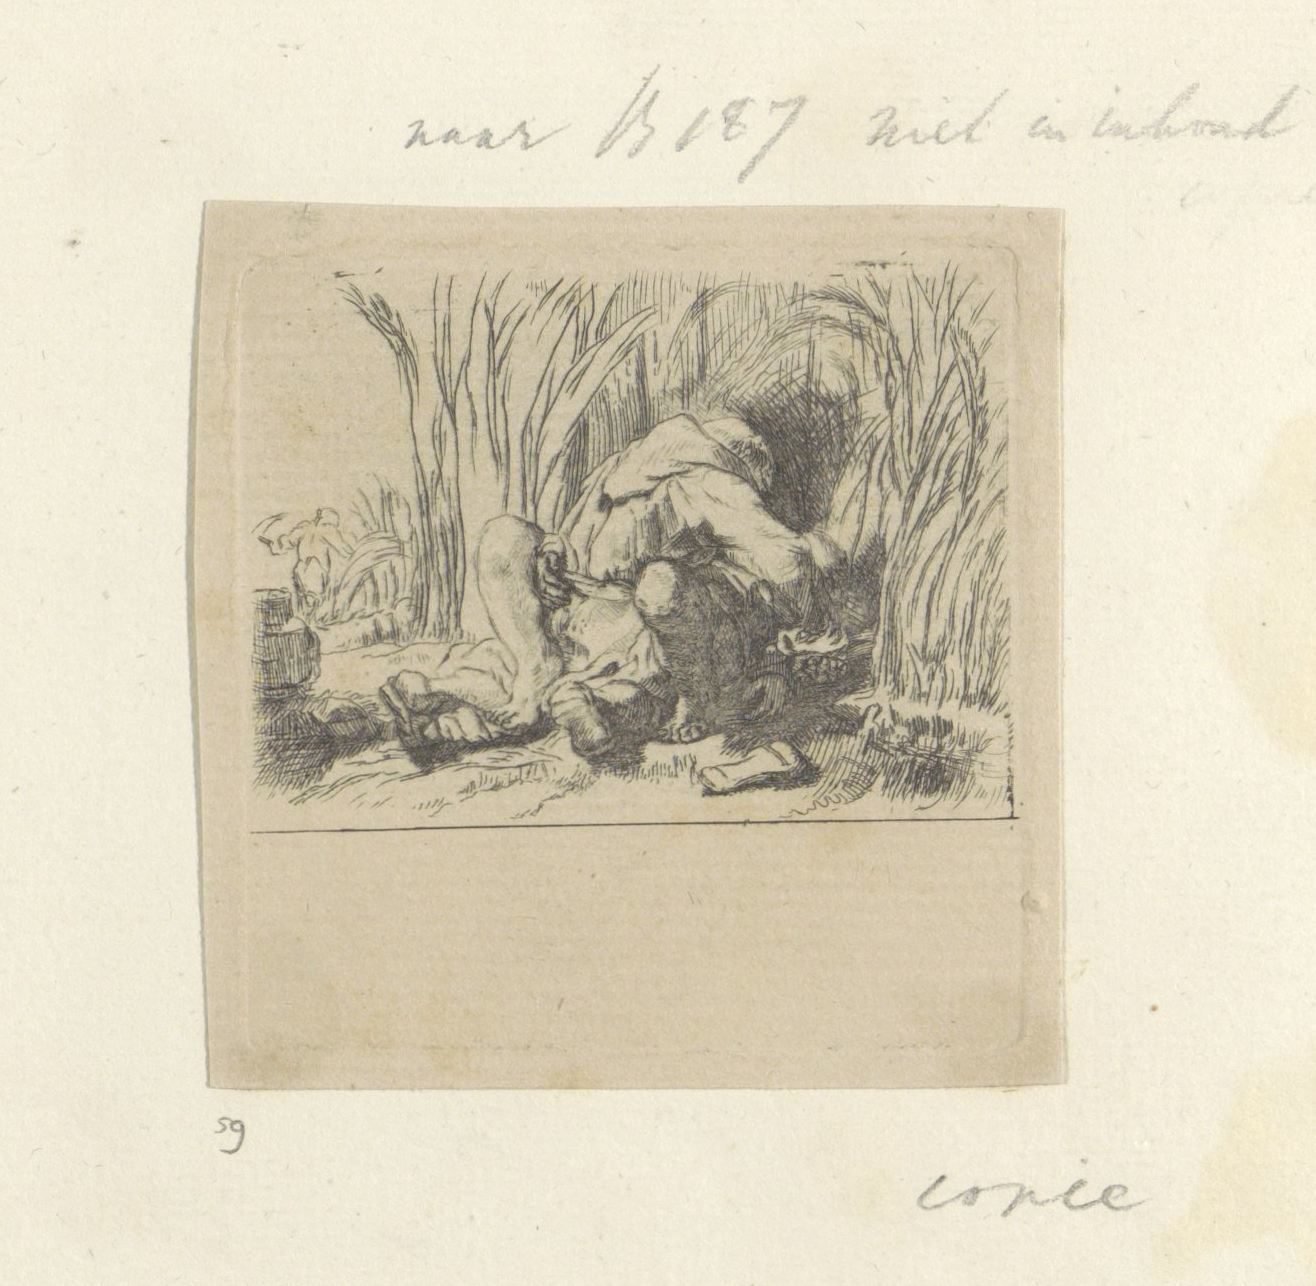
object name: album leaf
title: Monnik in het koren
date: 1644-1807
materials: paper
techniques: etching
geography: paris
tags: monk(s), friar(s), coitus, cohabiting, sexual intercourse